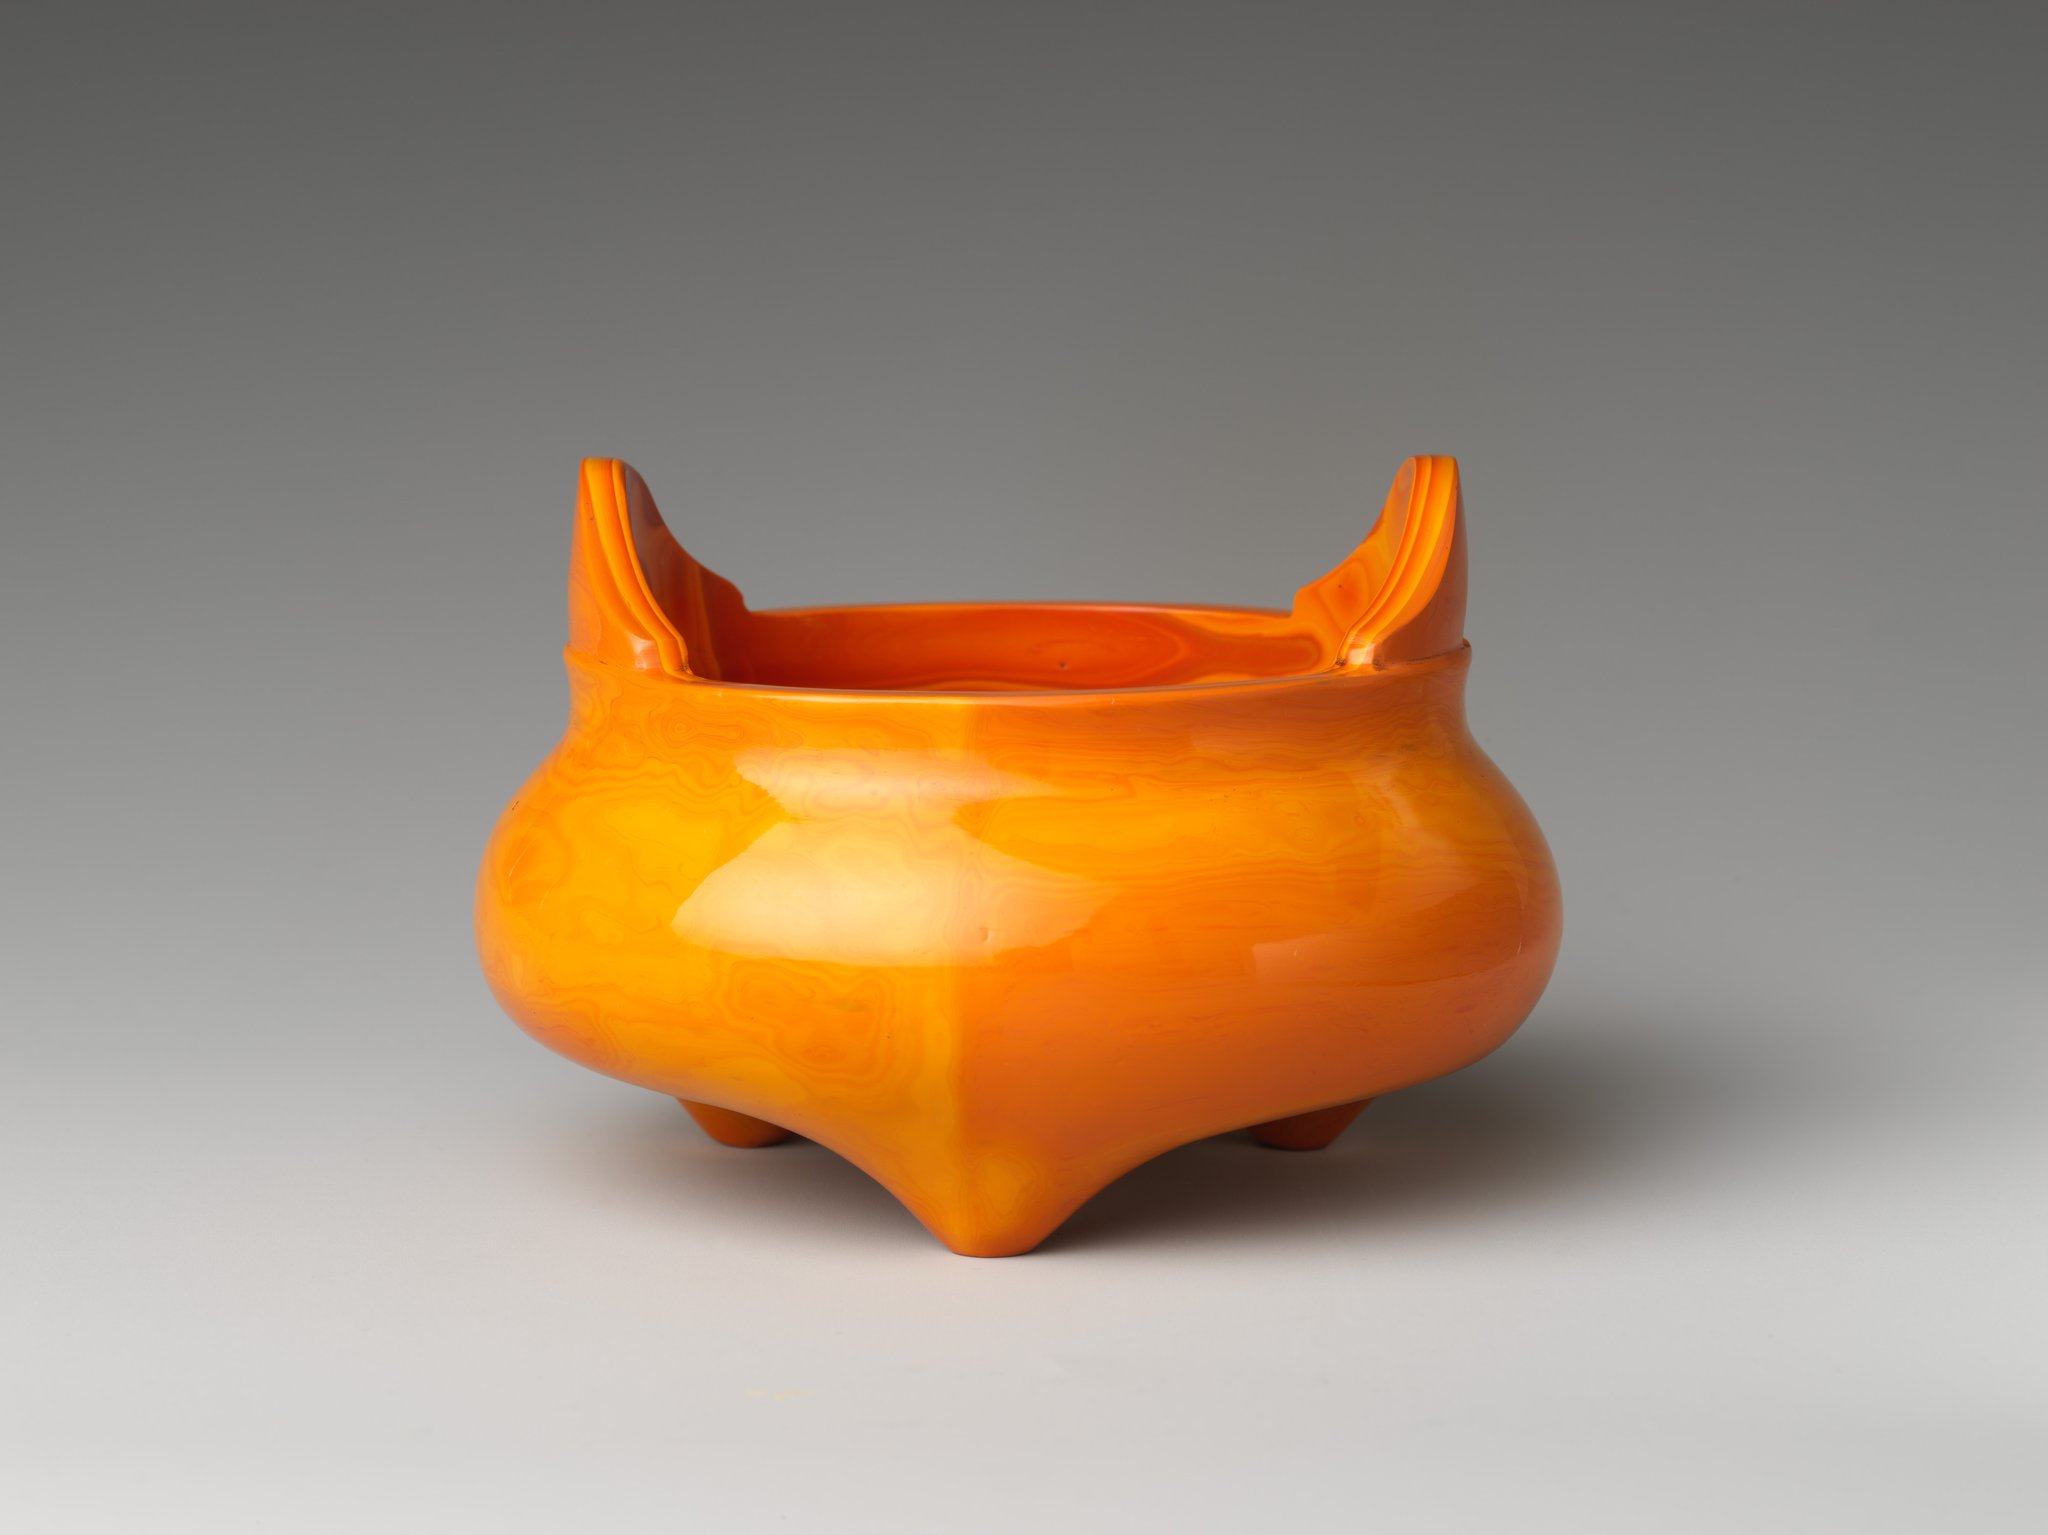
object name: censer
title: Tripod censer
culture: chinese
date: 1734-1766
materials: glass